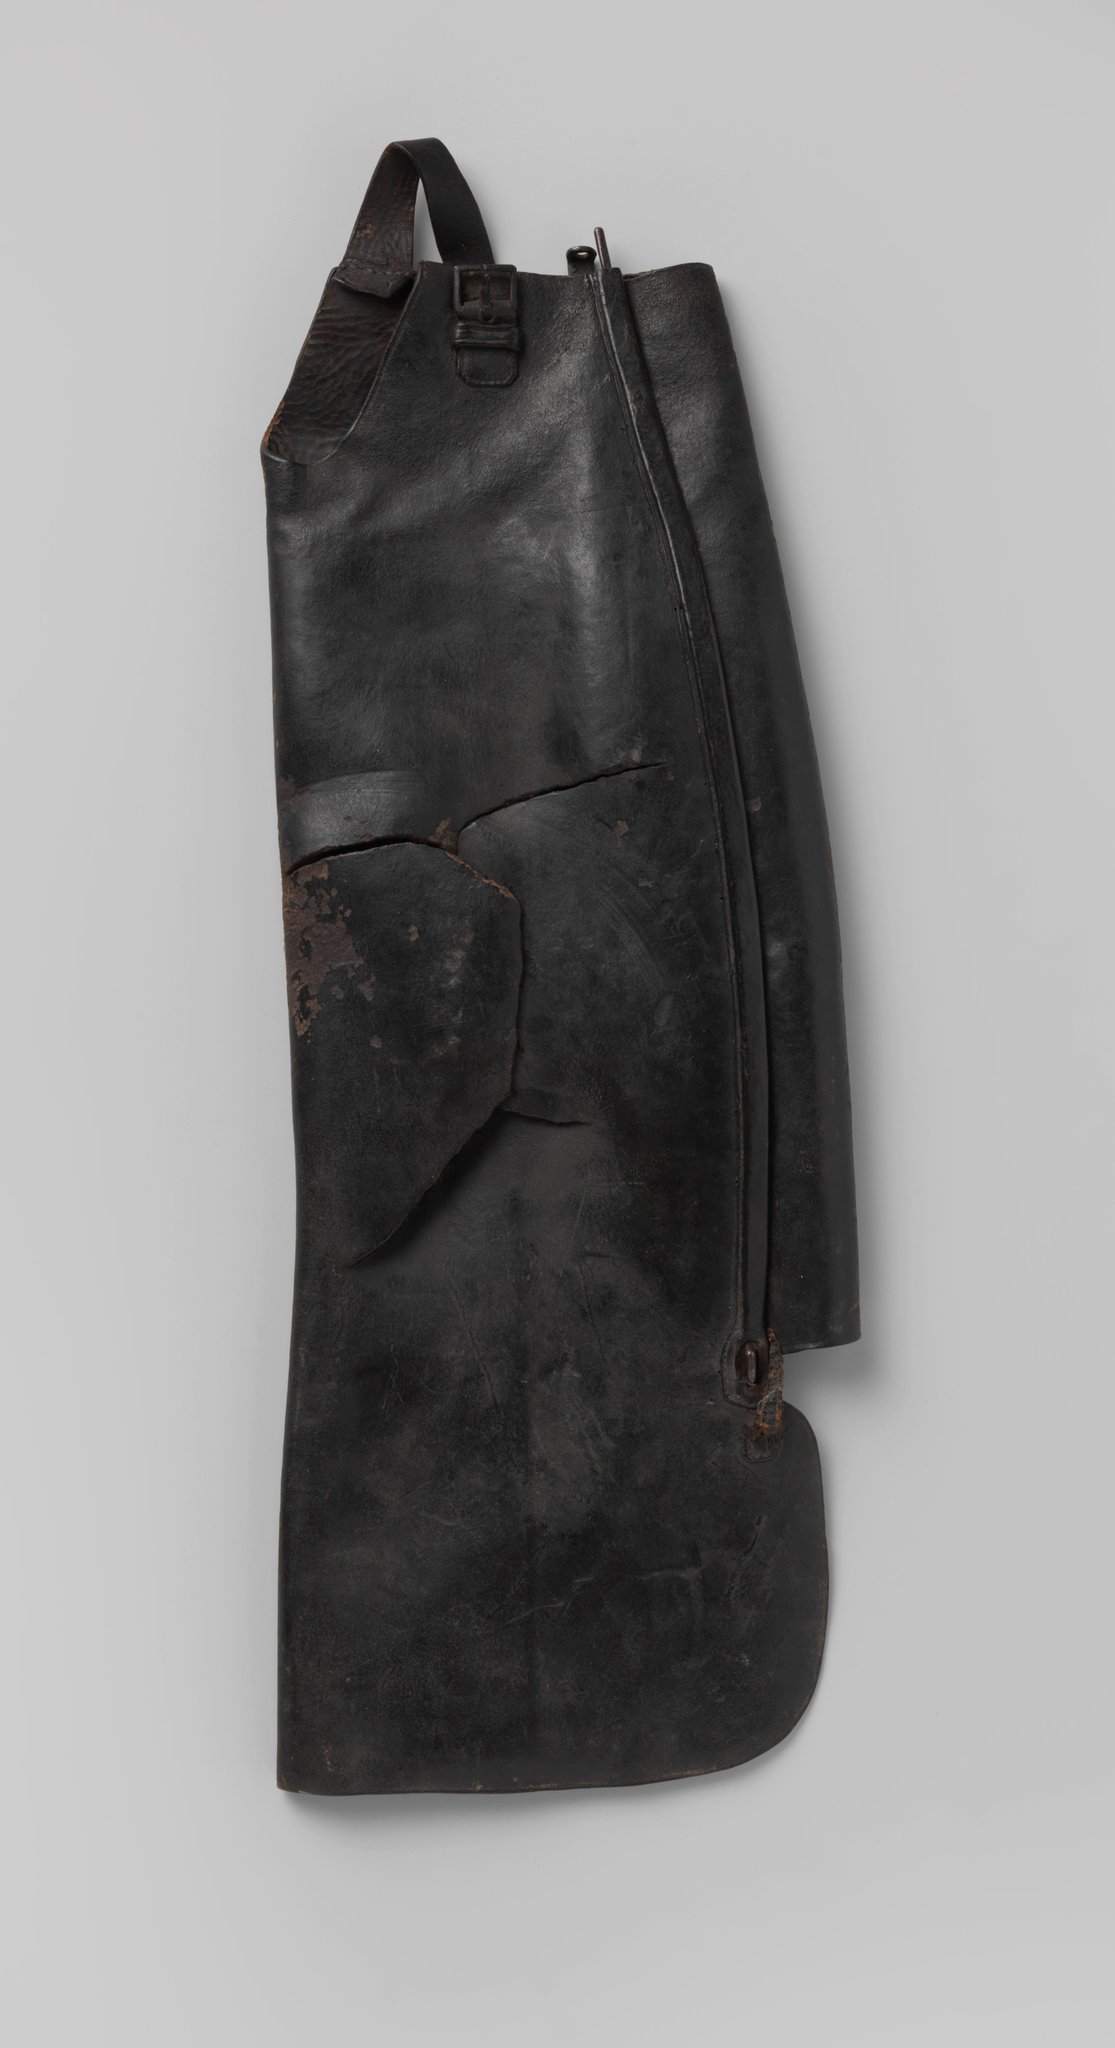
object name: gamaschen, beenbeschermer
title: Beenkap gedragen door kolonel de Gallières, commandant van de 9e Afdeling Kurassiers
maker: Anonymous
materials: leather, metal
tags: austria, louvain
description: Zwart leren hogekap met bruin naturel leren binnenwerk. Bovenzijde inkepingen, hieronder een metalen oog waarin metalen vergrendeling. Hierboven een leren lip. Onderzijde metalen pin en aan de andere zijde metalen staaf met gat. Hiervoor een leren riem met zes gaten. Aan de andere zijde een zwart metalen gesp met zwart leren lus. Gedragen door kolonel de Gallières, gewond aan het been bij Leuven 12 augustus 1831. Beenkap is doorboord door een kogel.